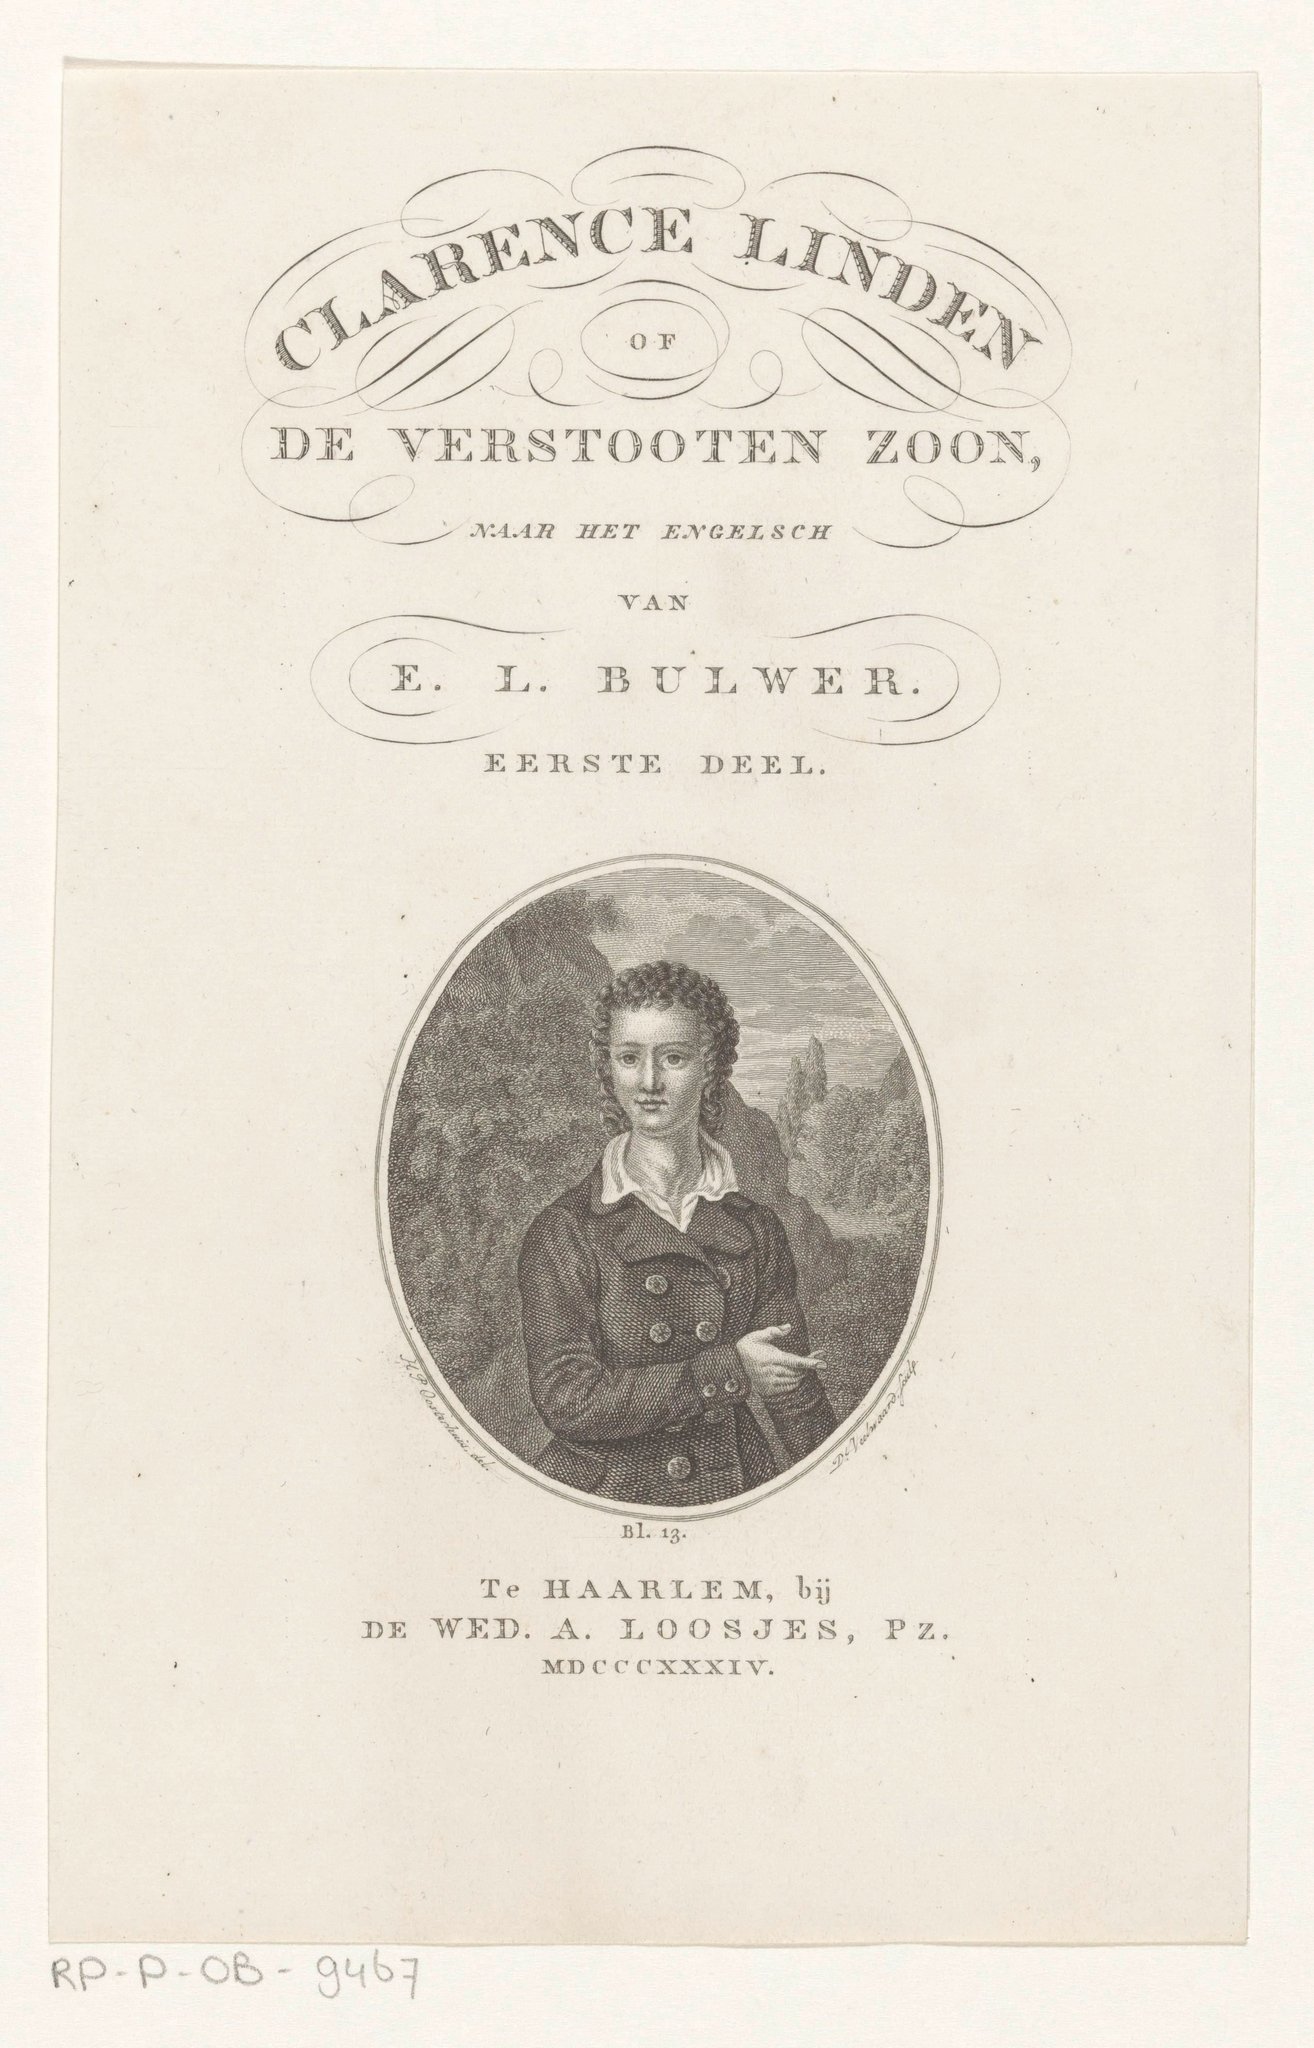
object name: titelblad, titelpagina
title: Portret van een jongeman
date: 1834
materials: paper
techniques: engraving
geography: haarlem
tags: youth, adolescent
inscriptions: collector's mark: Lugt 2228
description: Titelpagina voor: Bulwer, E.L. Clarence Linden of de verstooten zoon. Haarlem: Loosjes Pz., weduwe Adriaan, 1834.